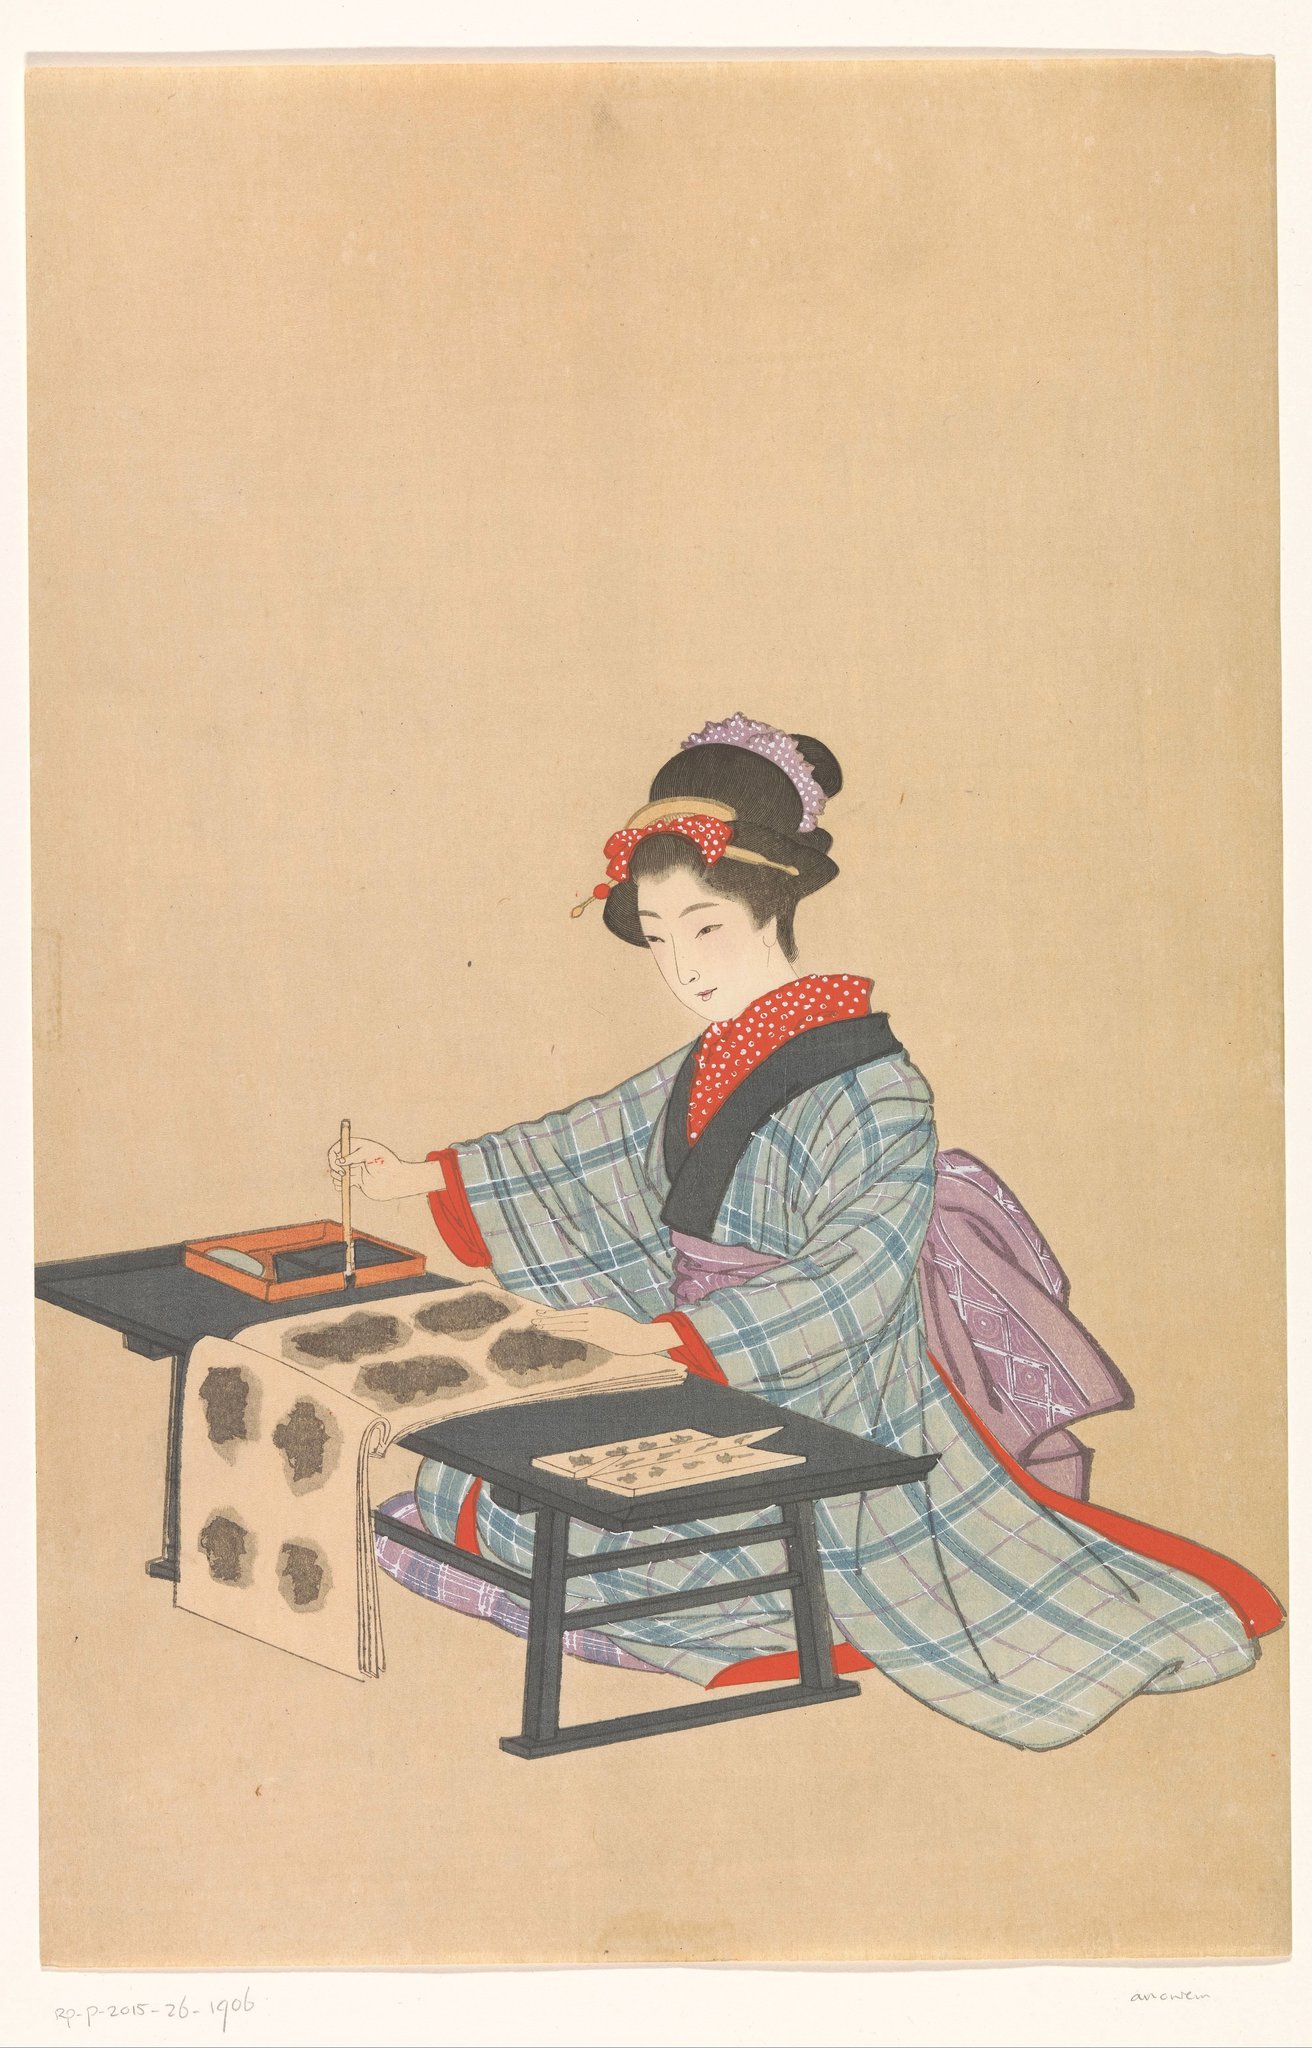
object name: print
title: Kalligraferende vrouw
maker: Anonymous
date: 1800-1899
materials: paper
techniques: woodcut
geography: japan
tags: calligraphy